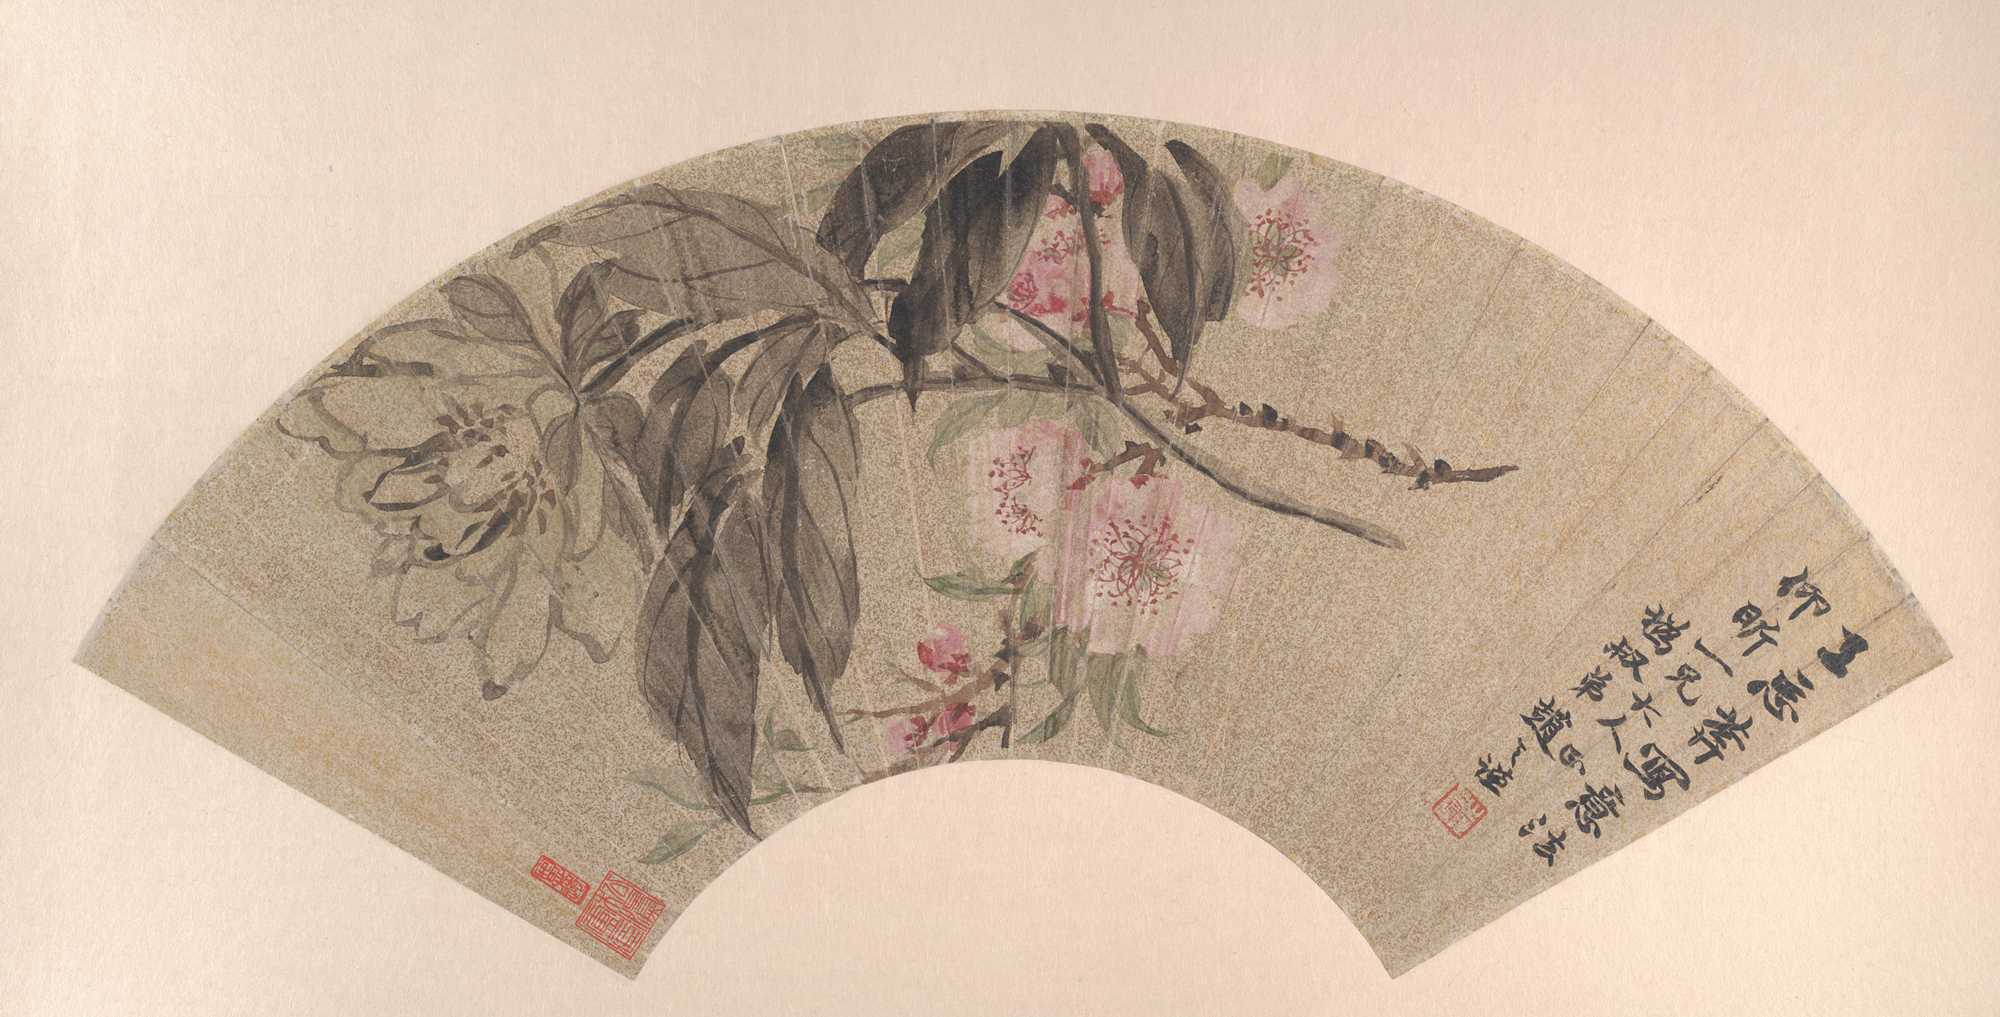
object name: folding fan mounted a an album leaf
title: Peach Blossoms and Peony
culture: chinese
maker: zhao zhiqian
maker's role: artist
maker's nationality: chinese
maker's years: 1829-1884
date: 1860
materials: gold, ink, paper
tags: peonies